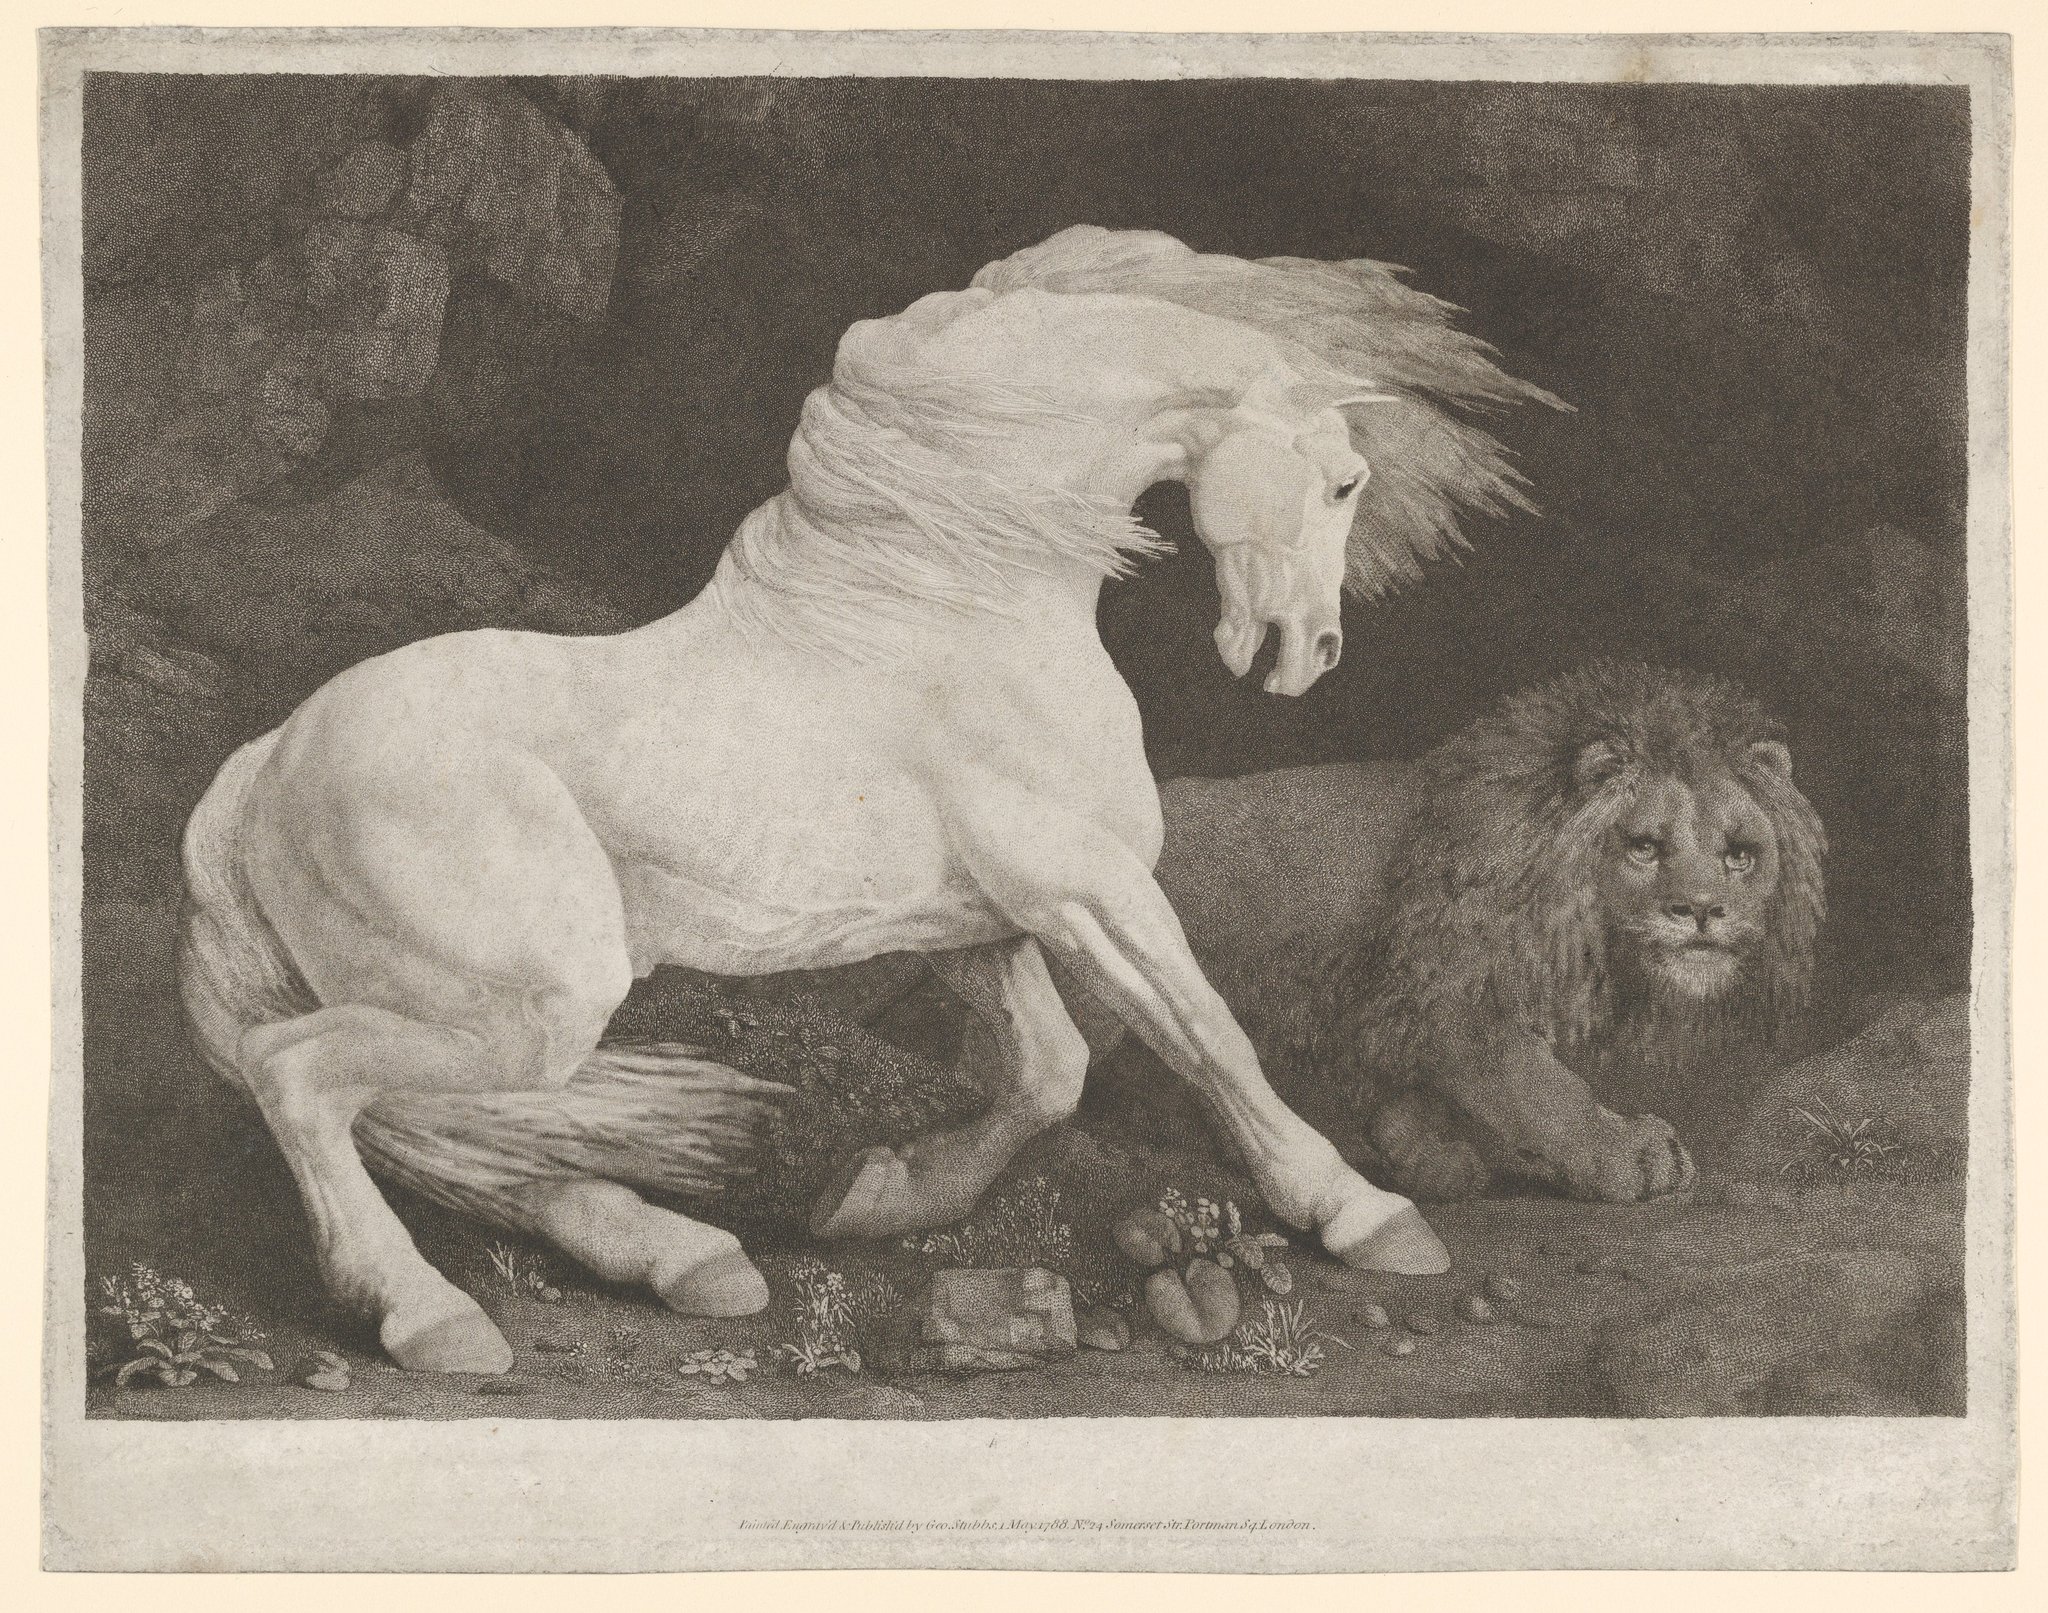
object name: print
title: A Horse Affrighted at a Lion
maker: george stubbs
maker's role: artist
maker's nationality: british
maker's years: 1724-1806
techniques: etching, roulette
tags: horses,lions